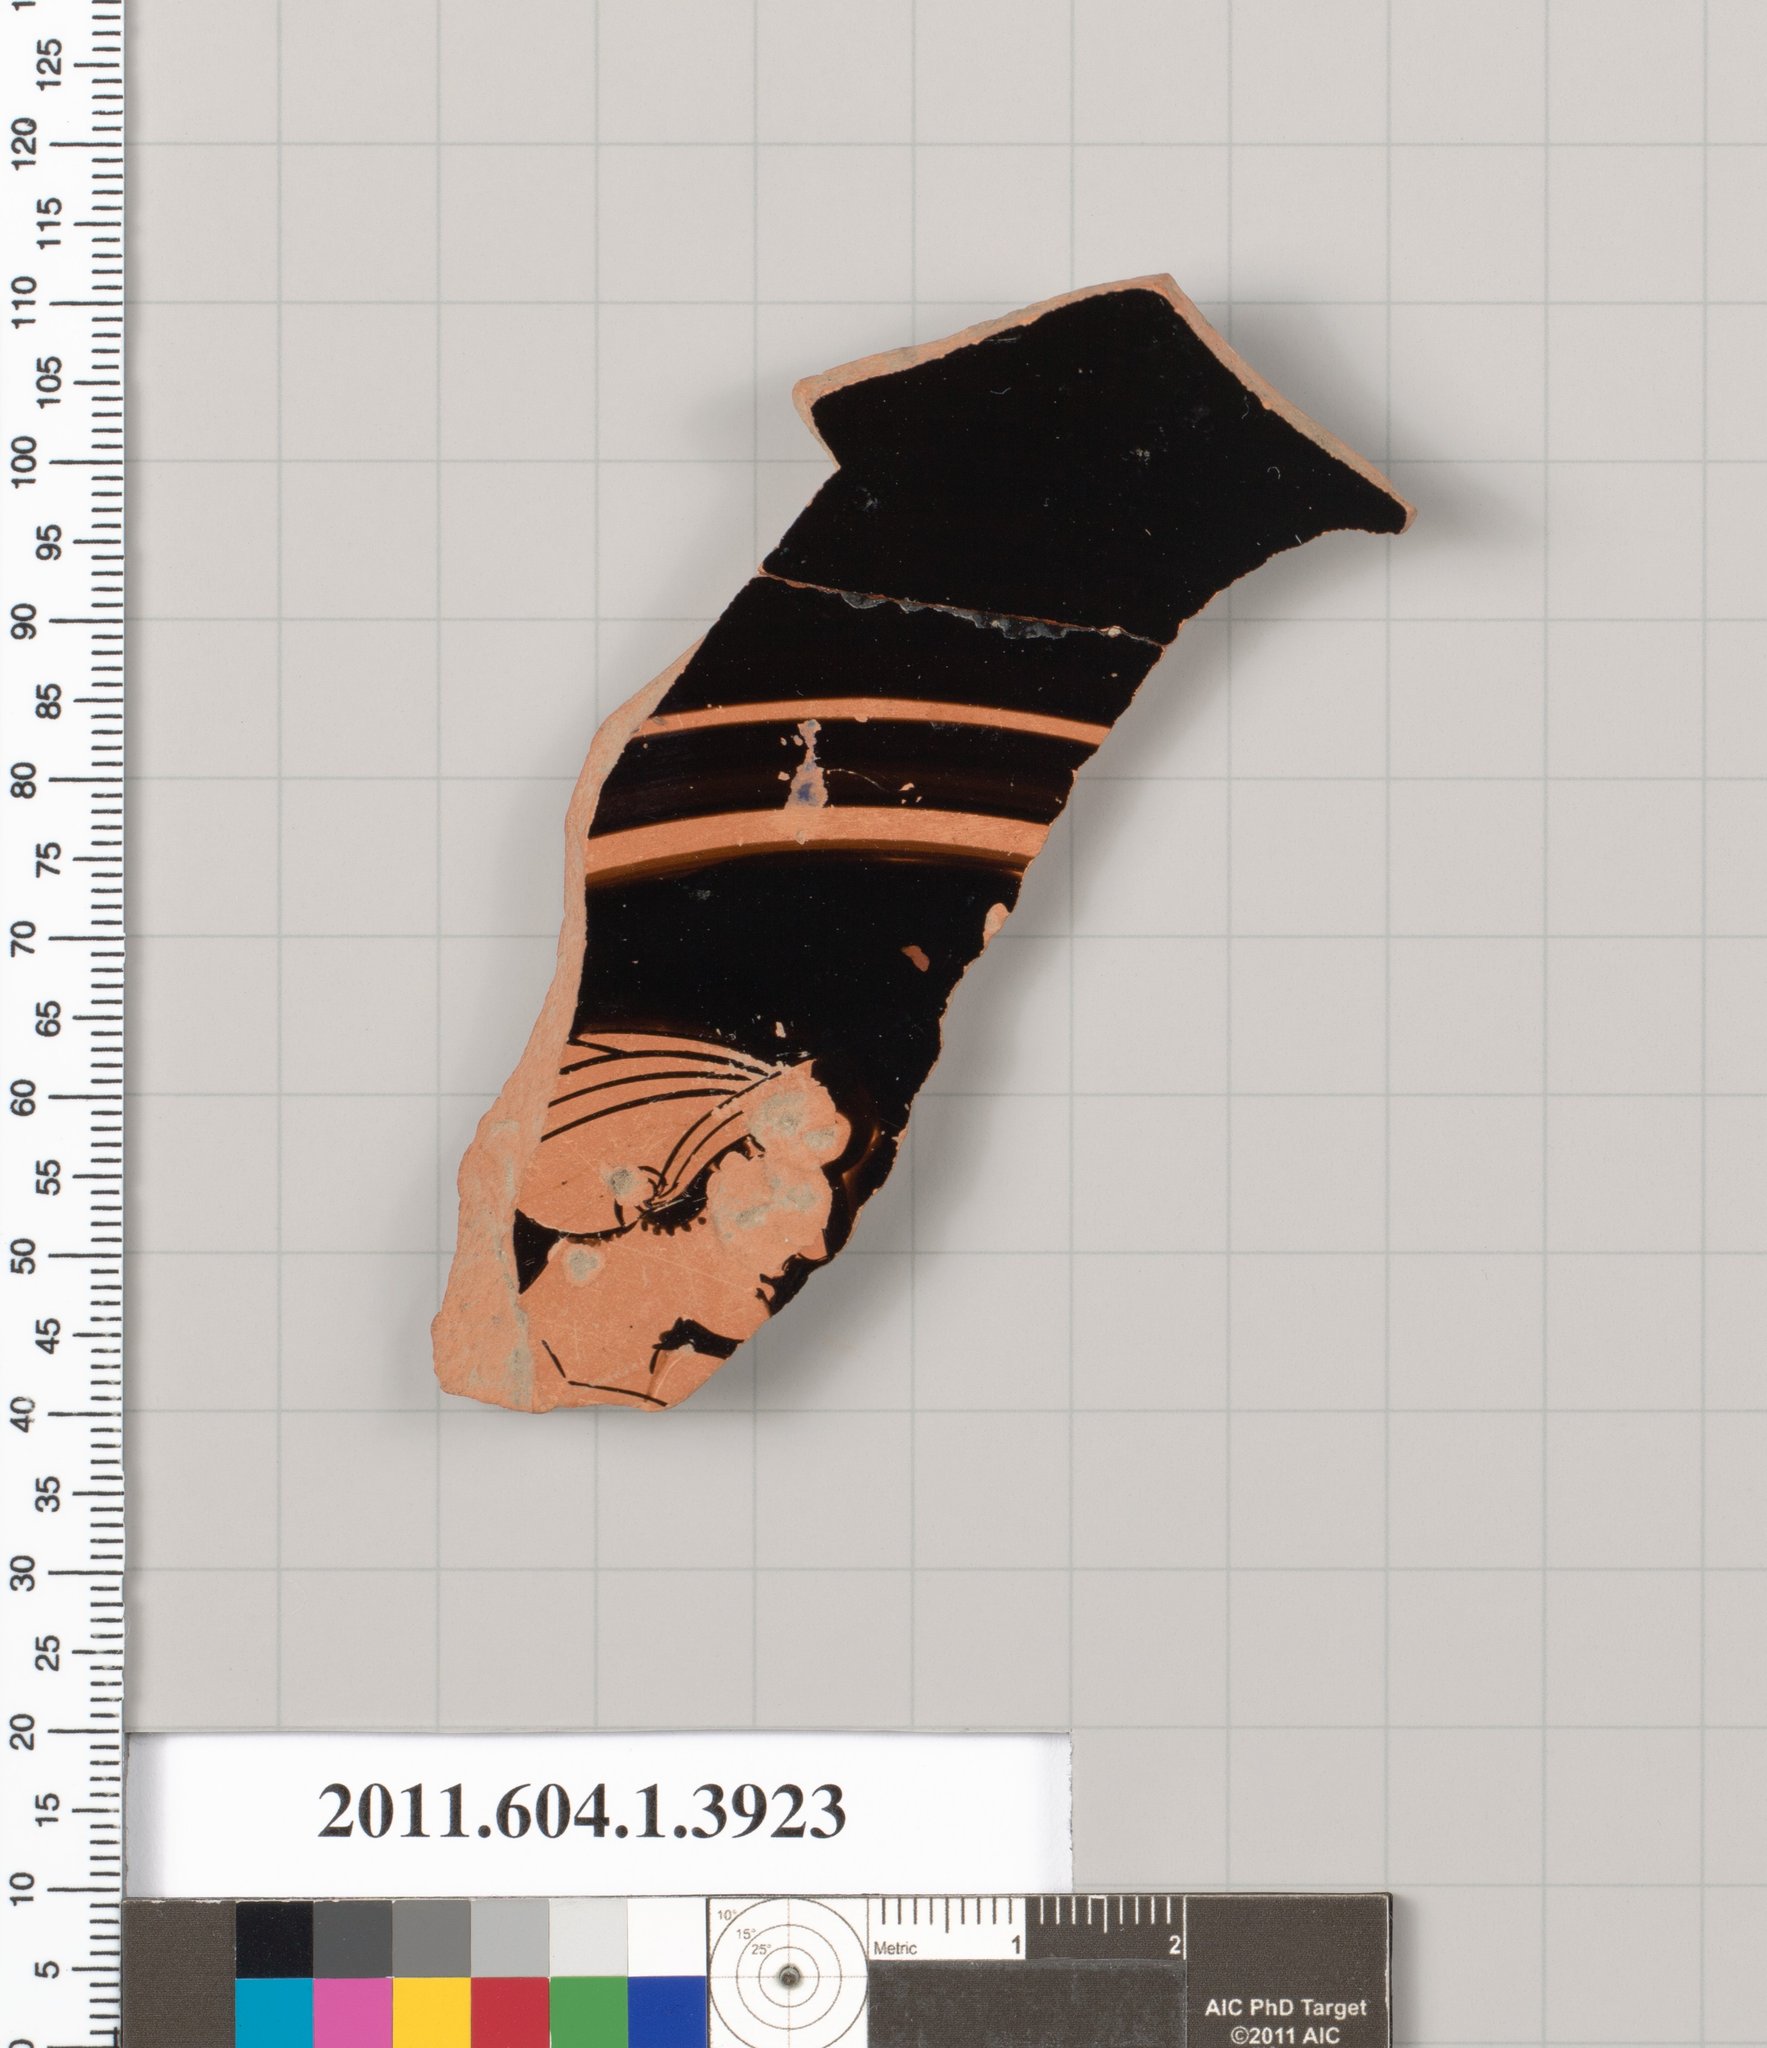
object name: kylix fragment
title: Terracotta fragment of a kylix (drinking cup)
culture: greek, attic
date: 567-600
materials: terracotta